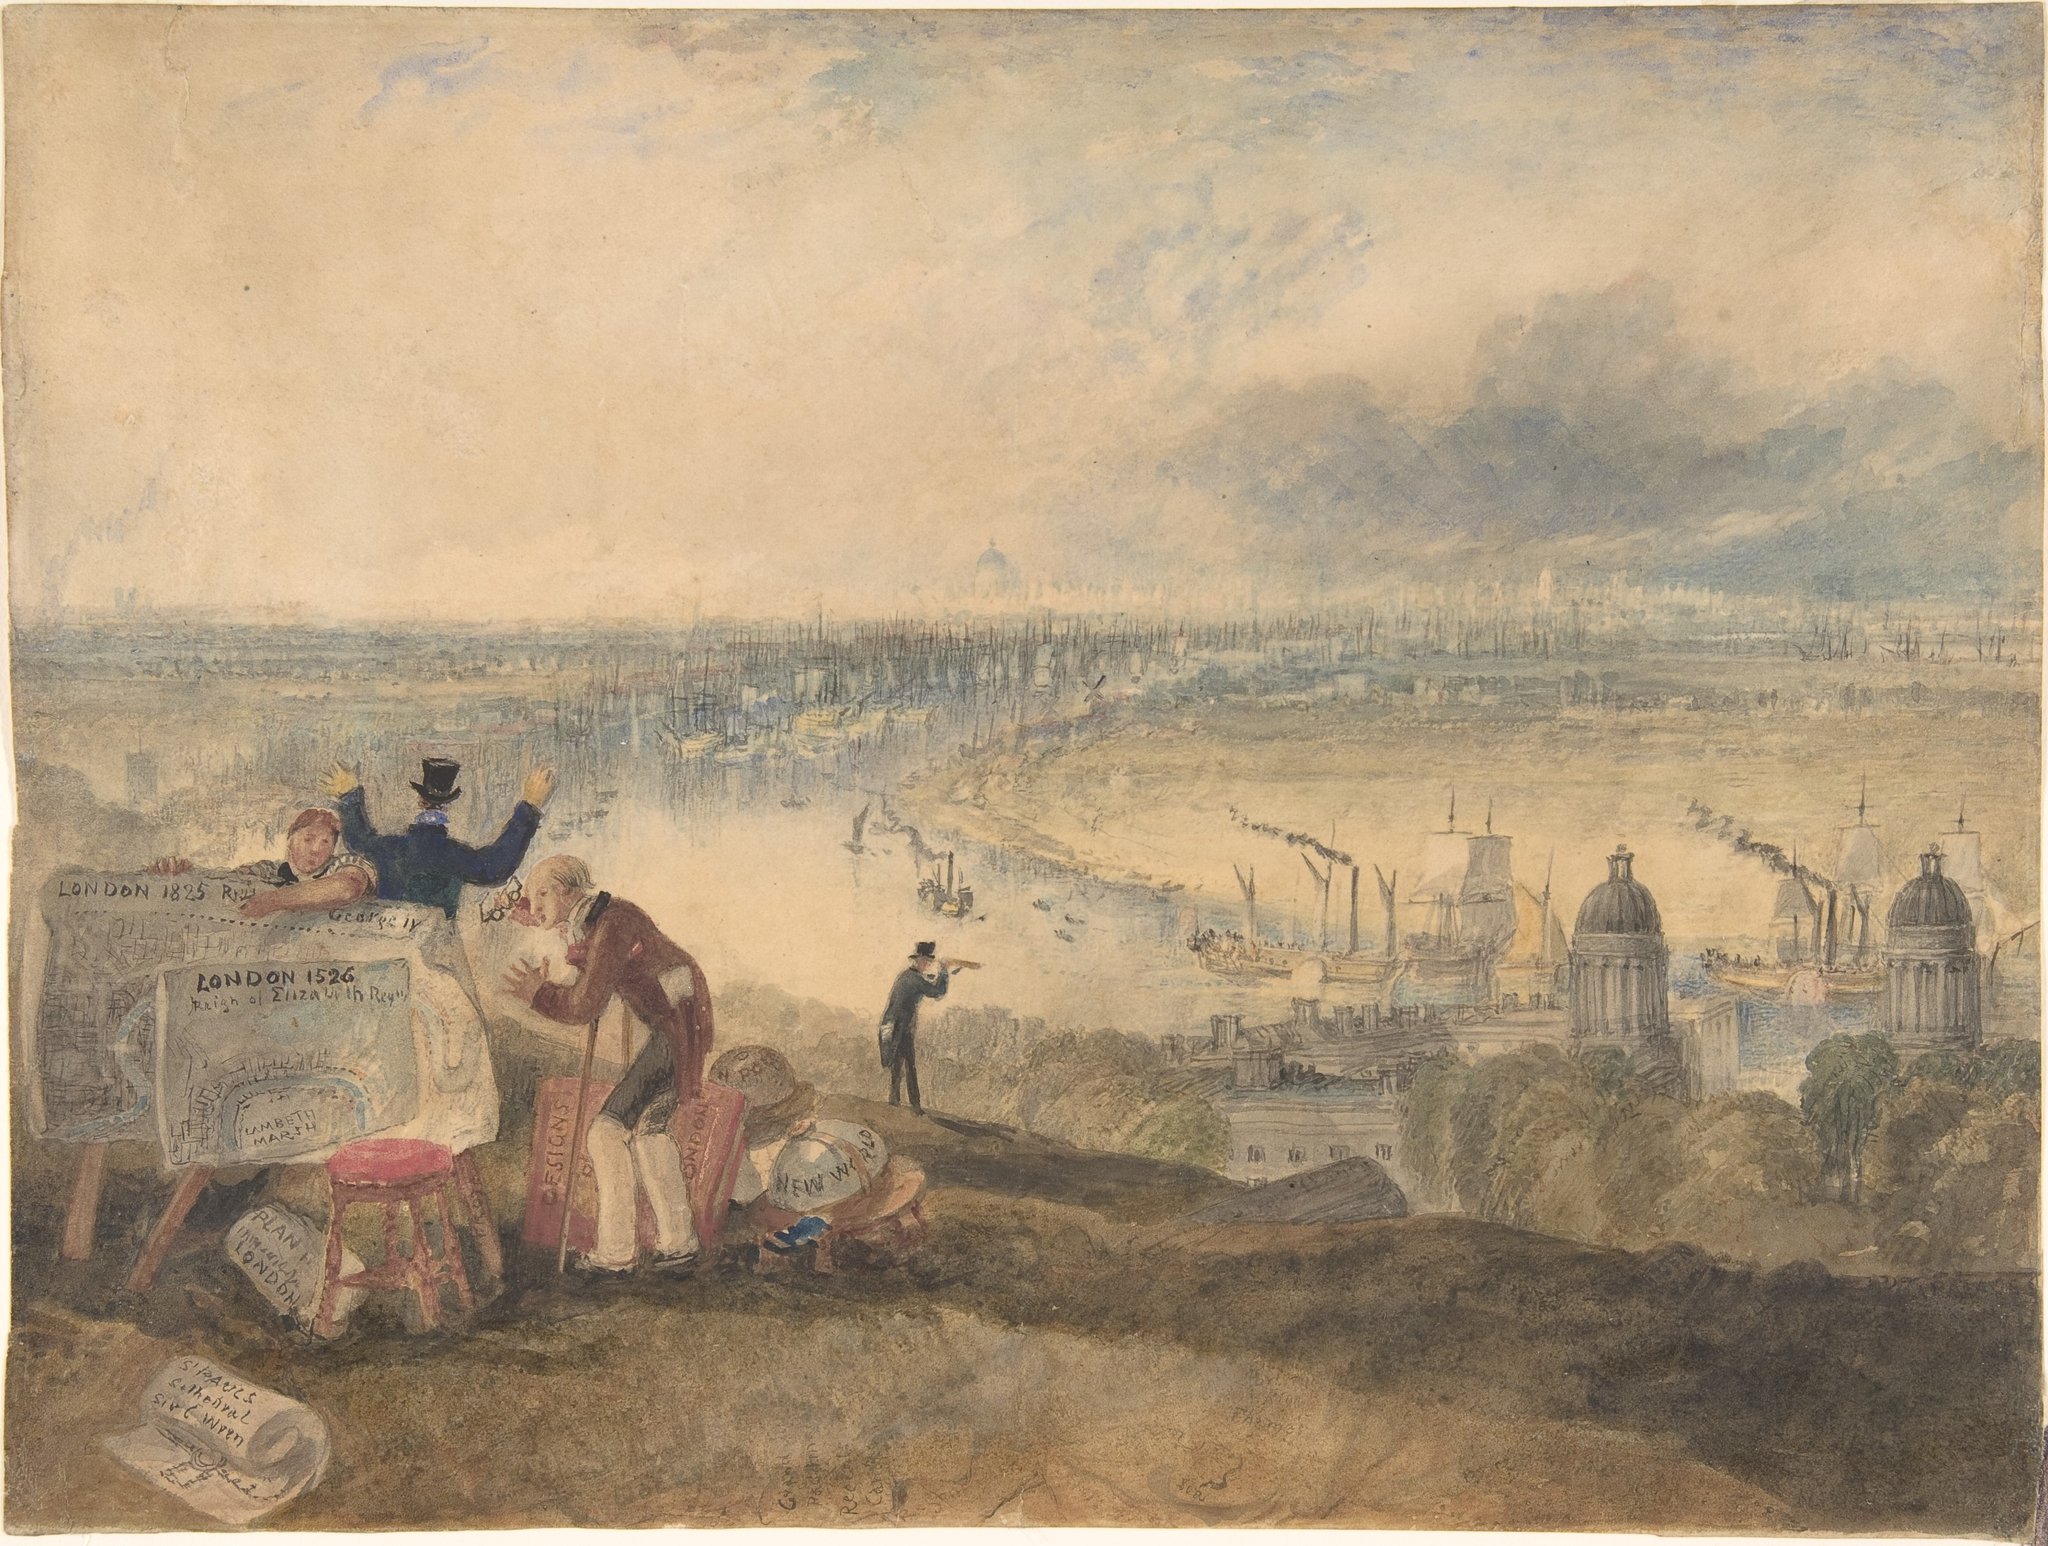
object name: drawing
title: View of London from Greenwich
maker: joseph mallord william turner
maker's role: artist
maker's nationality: british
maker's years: 1775-1851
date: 1825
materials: graphite, ink, watercolor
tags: cities,rivers,landscapes,london